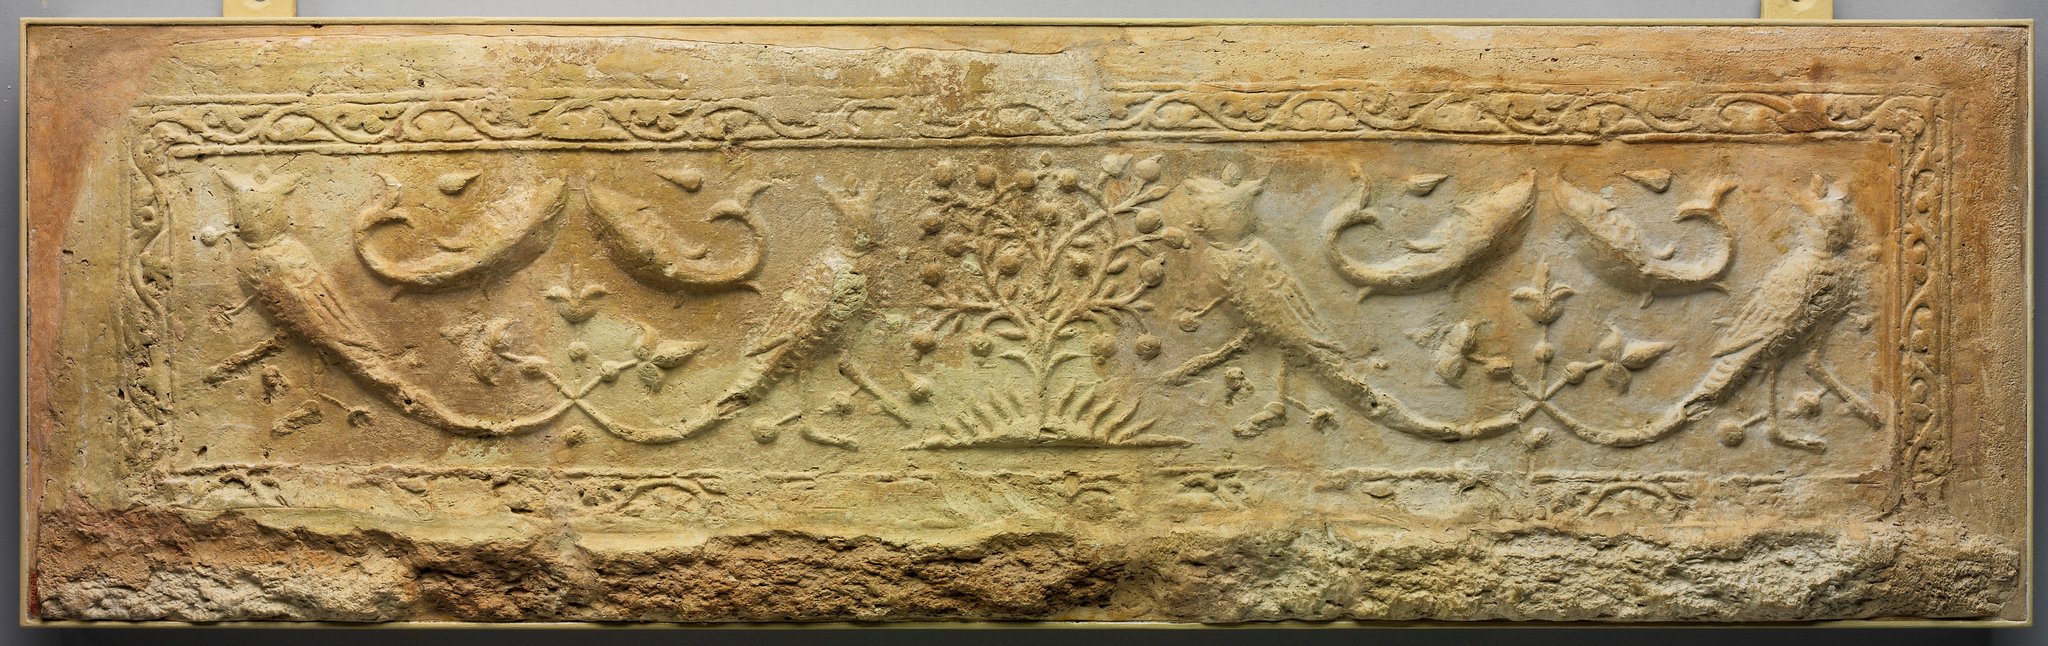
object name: panel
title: Panel with Harpies, Fish, and Trees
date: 1001-1200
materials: terracotta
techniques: molding, painting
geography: iran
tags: fish,trees